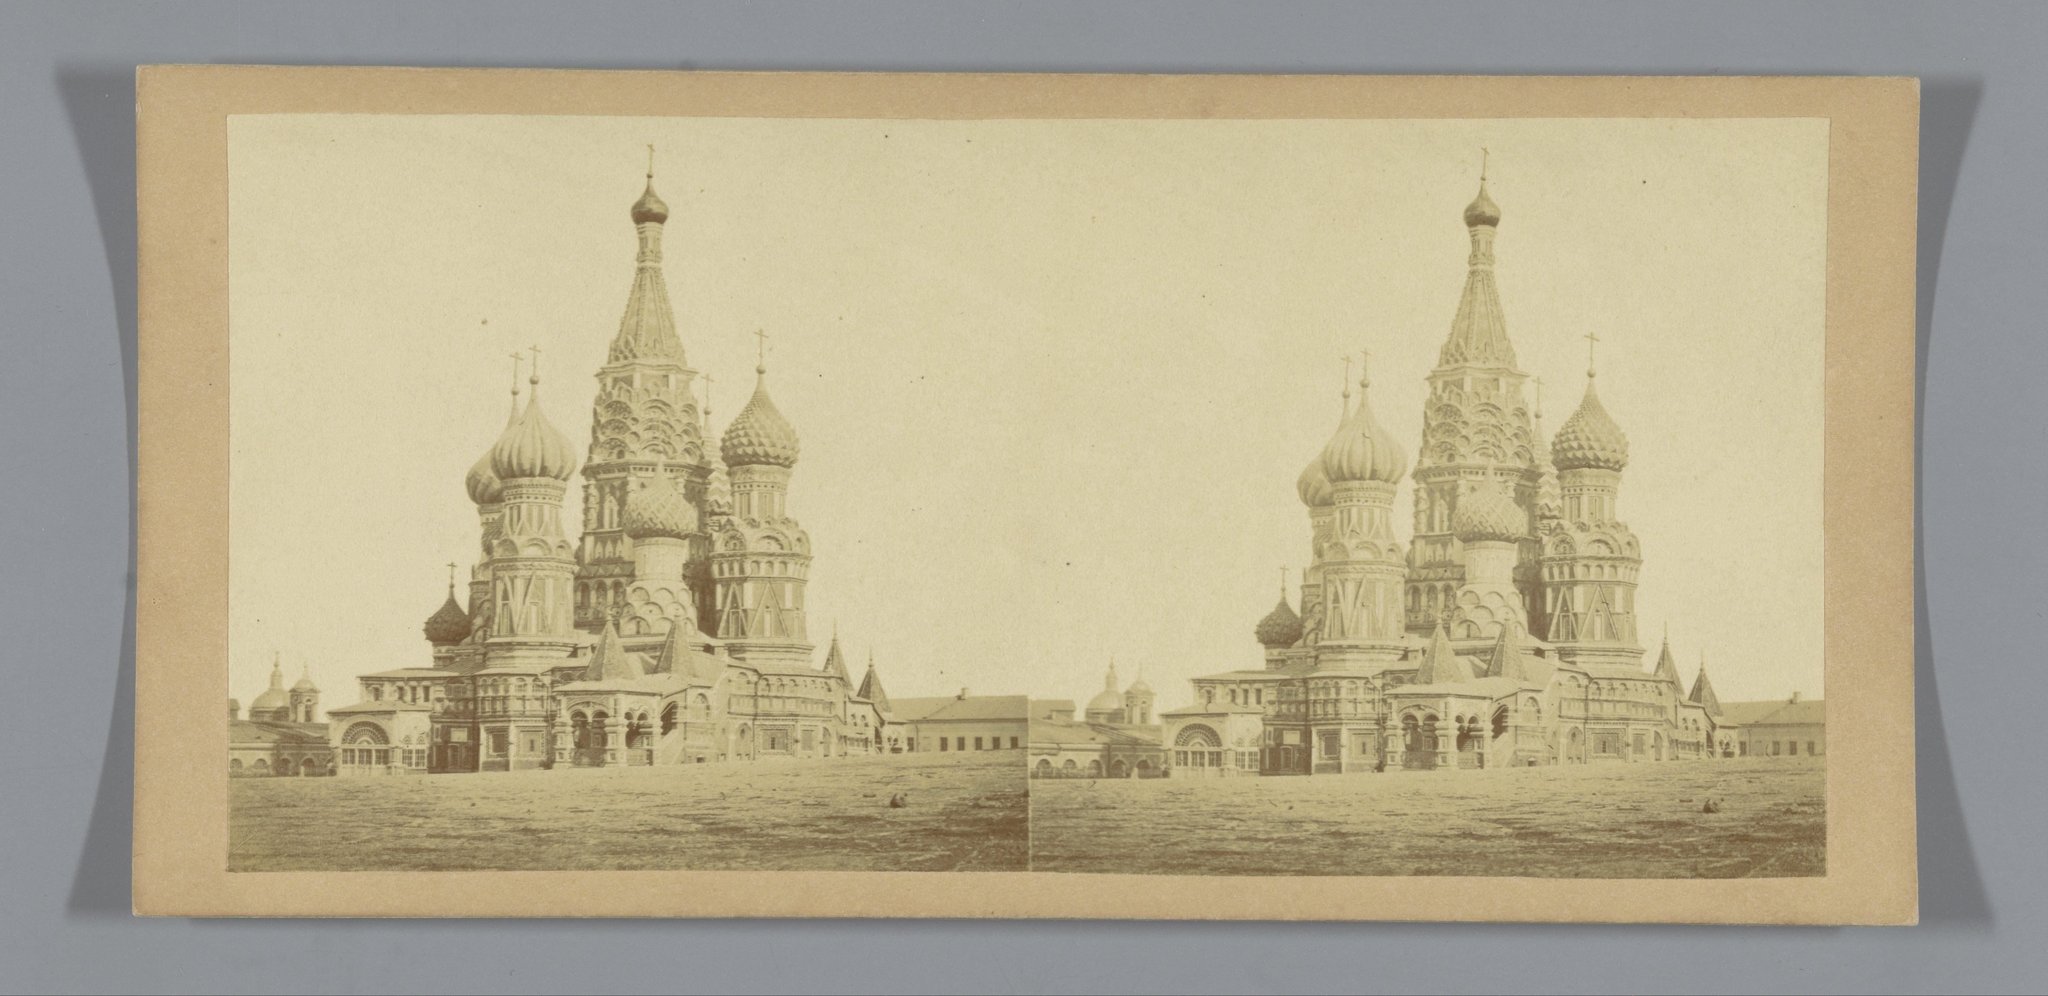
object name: stereograph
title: Gezicht op de Pokrovkathedraal van het Kremlin in Moskou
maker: Anonymous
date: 1850-1880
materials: cardboard, photographic support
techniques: albumen print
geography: moscow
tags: church (exterior)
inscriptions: inscription: ‘D. 12.’, inscription: ‘Eglise St. Bazile près du Bazar (Ville Chinoise)’